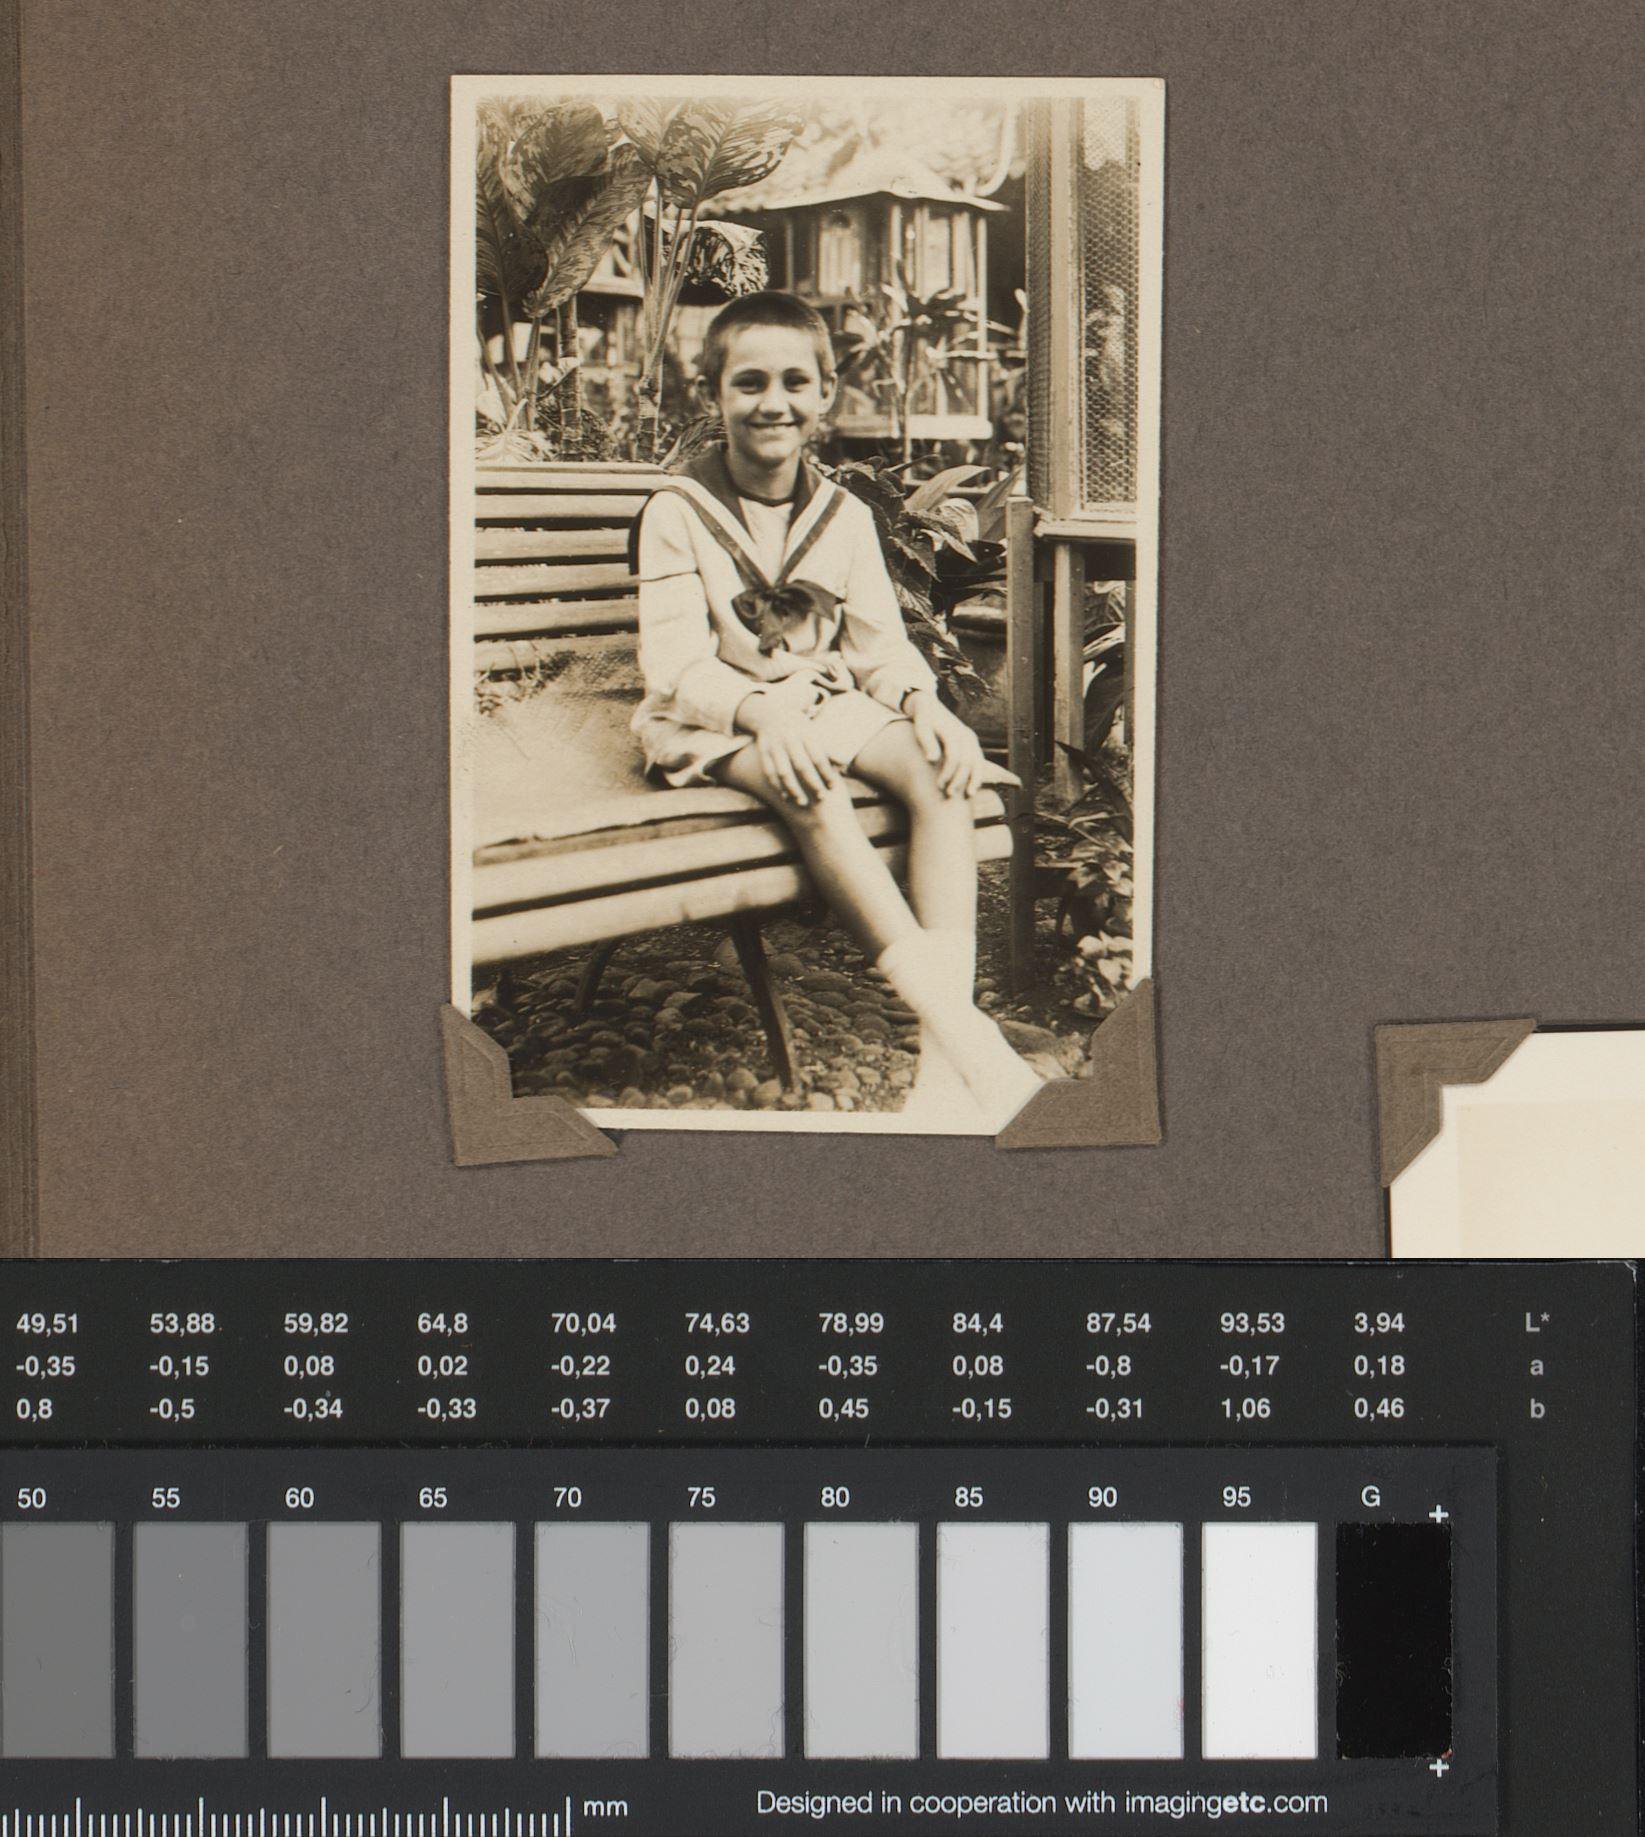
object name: photograph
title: Portret van Dicky Baud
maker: Anonymous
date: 1930-1935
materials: paper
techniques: gelatin silver print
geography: paris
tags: boy (child between toddler and youth), historical persons, paris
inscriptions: inscription: ‘Dicky./ Hepatrol./ A Rolland/ Paris’